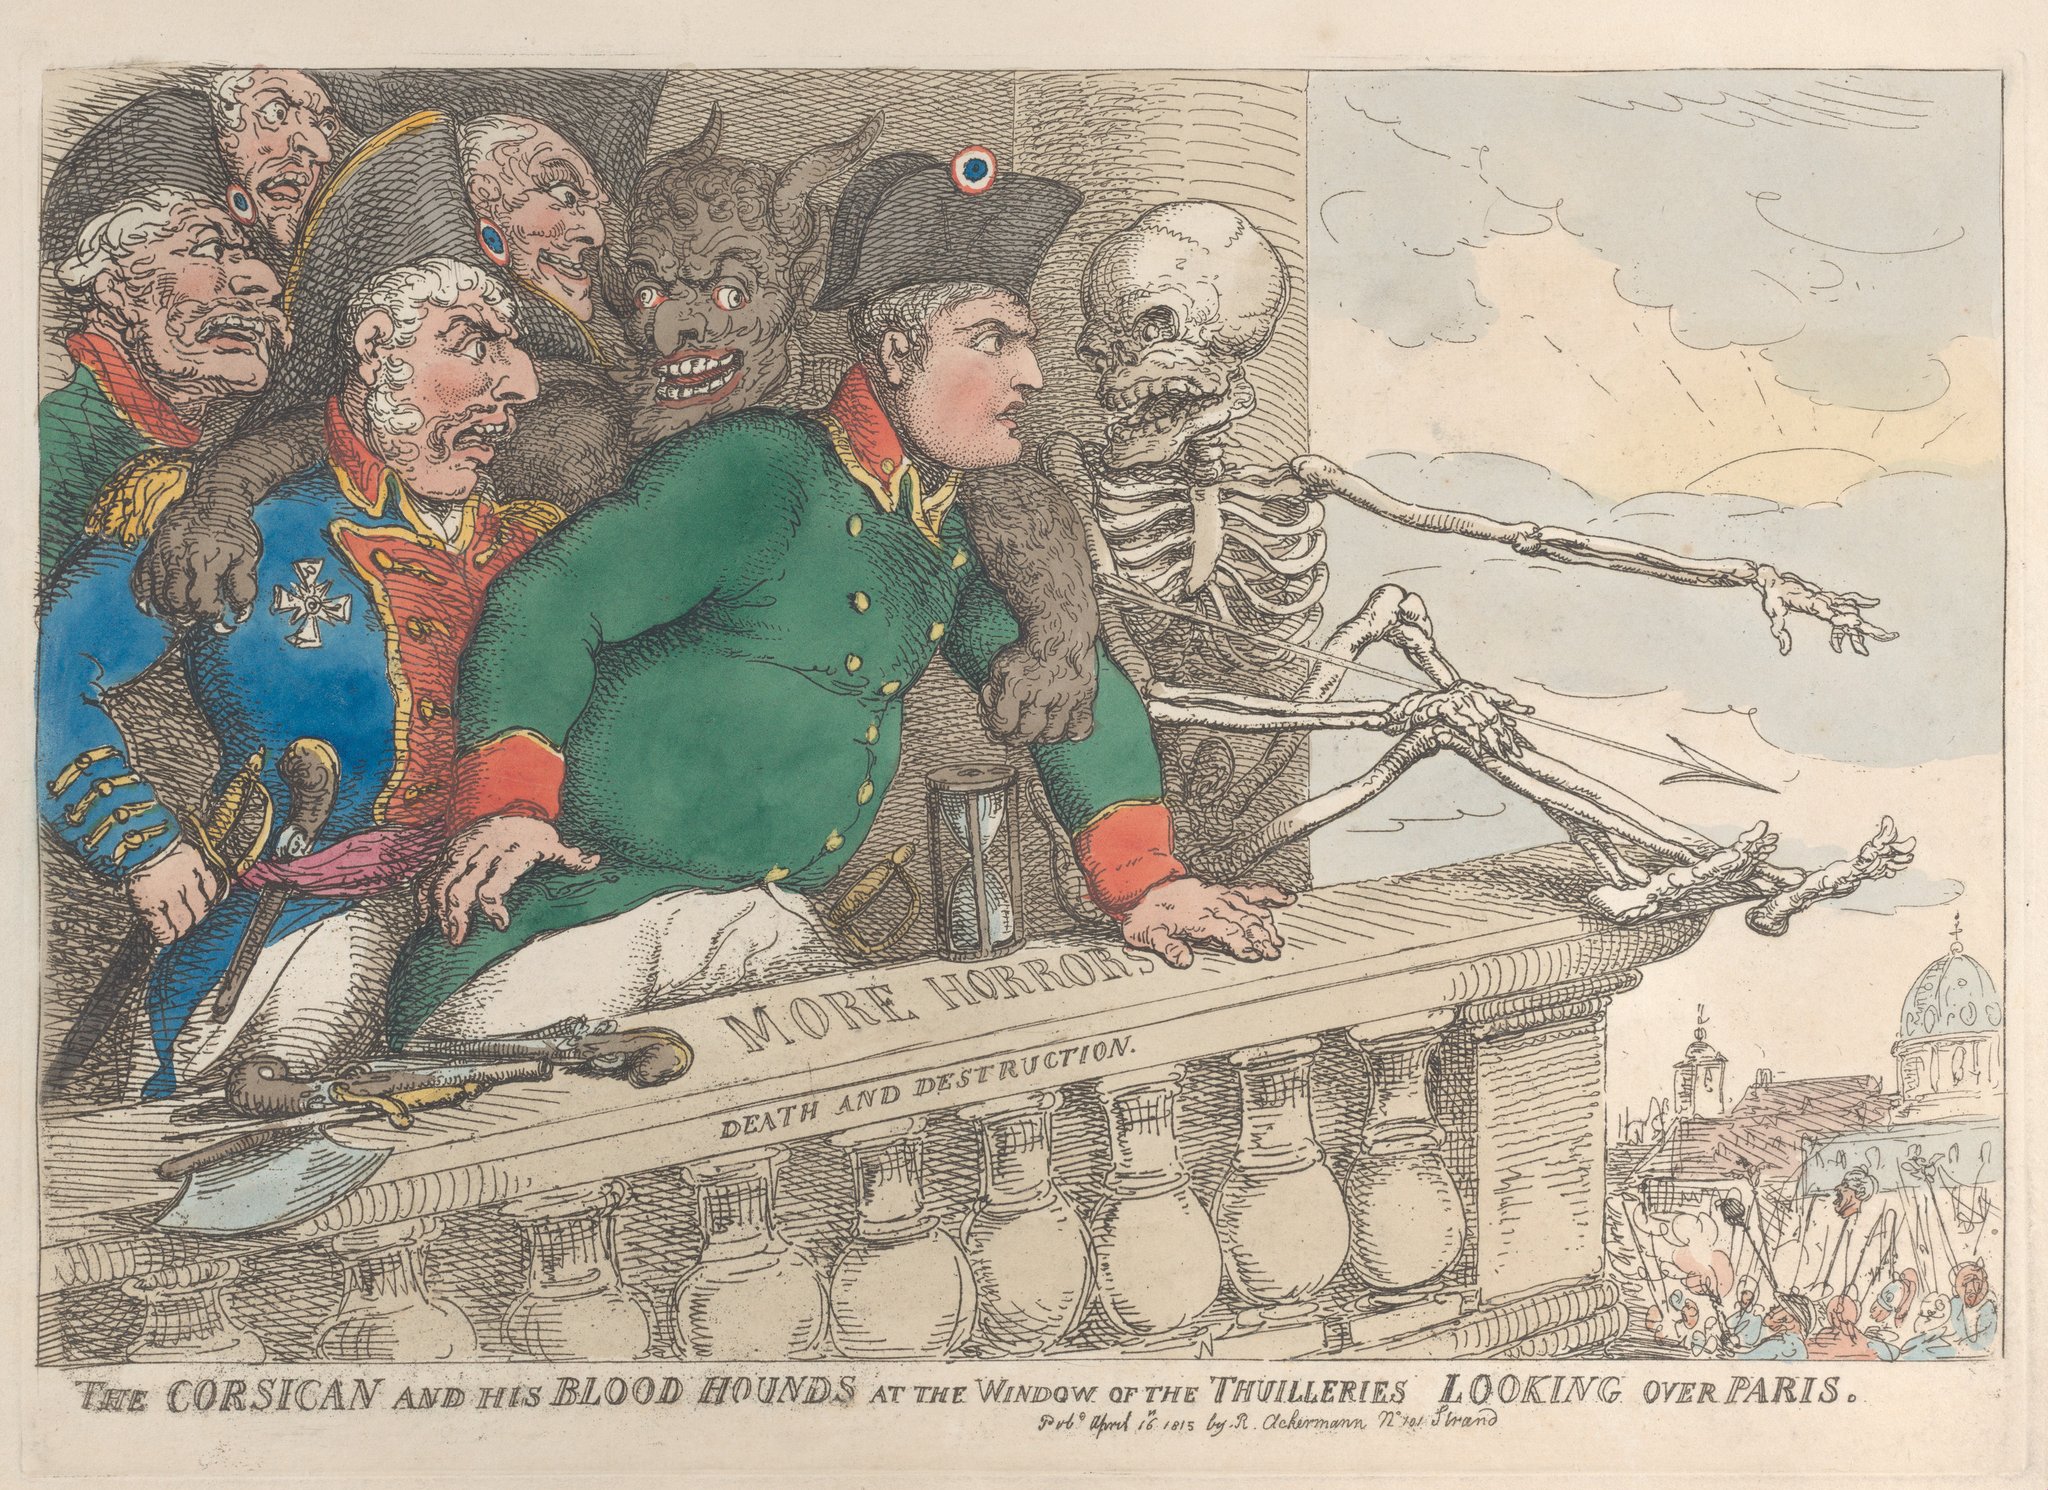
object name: print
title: The Corsican and His Bloodhounds at the Window of the Thuilleries Looking Over Paris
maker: thomas rowlandson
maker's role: artist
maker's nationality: british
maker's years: 1757-1827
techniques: etching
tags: satire,napoleon i,skeletons,devil,politics